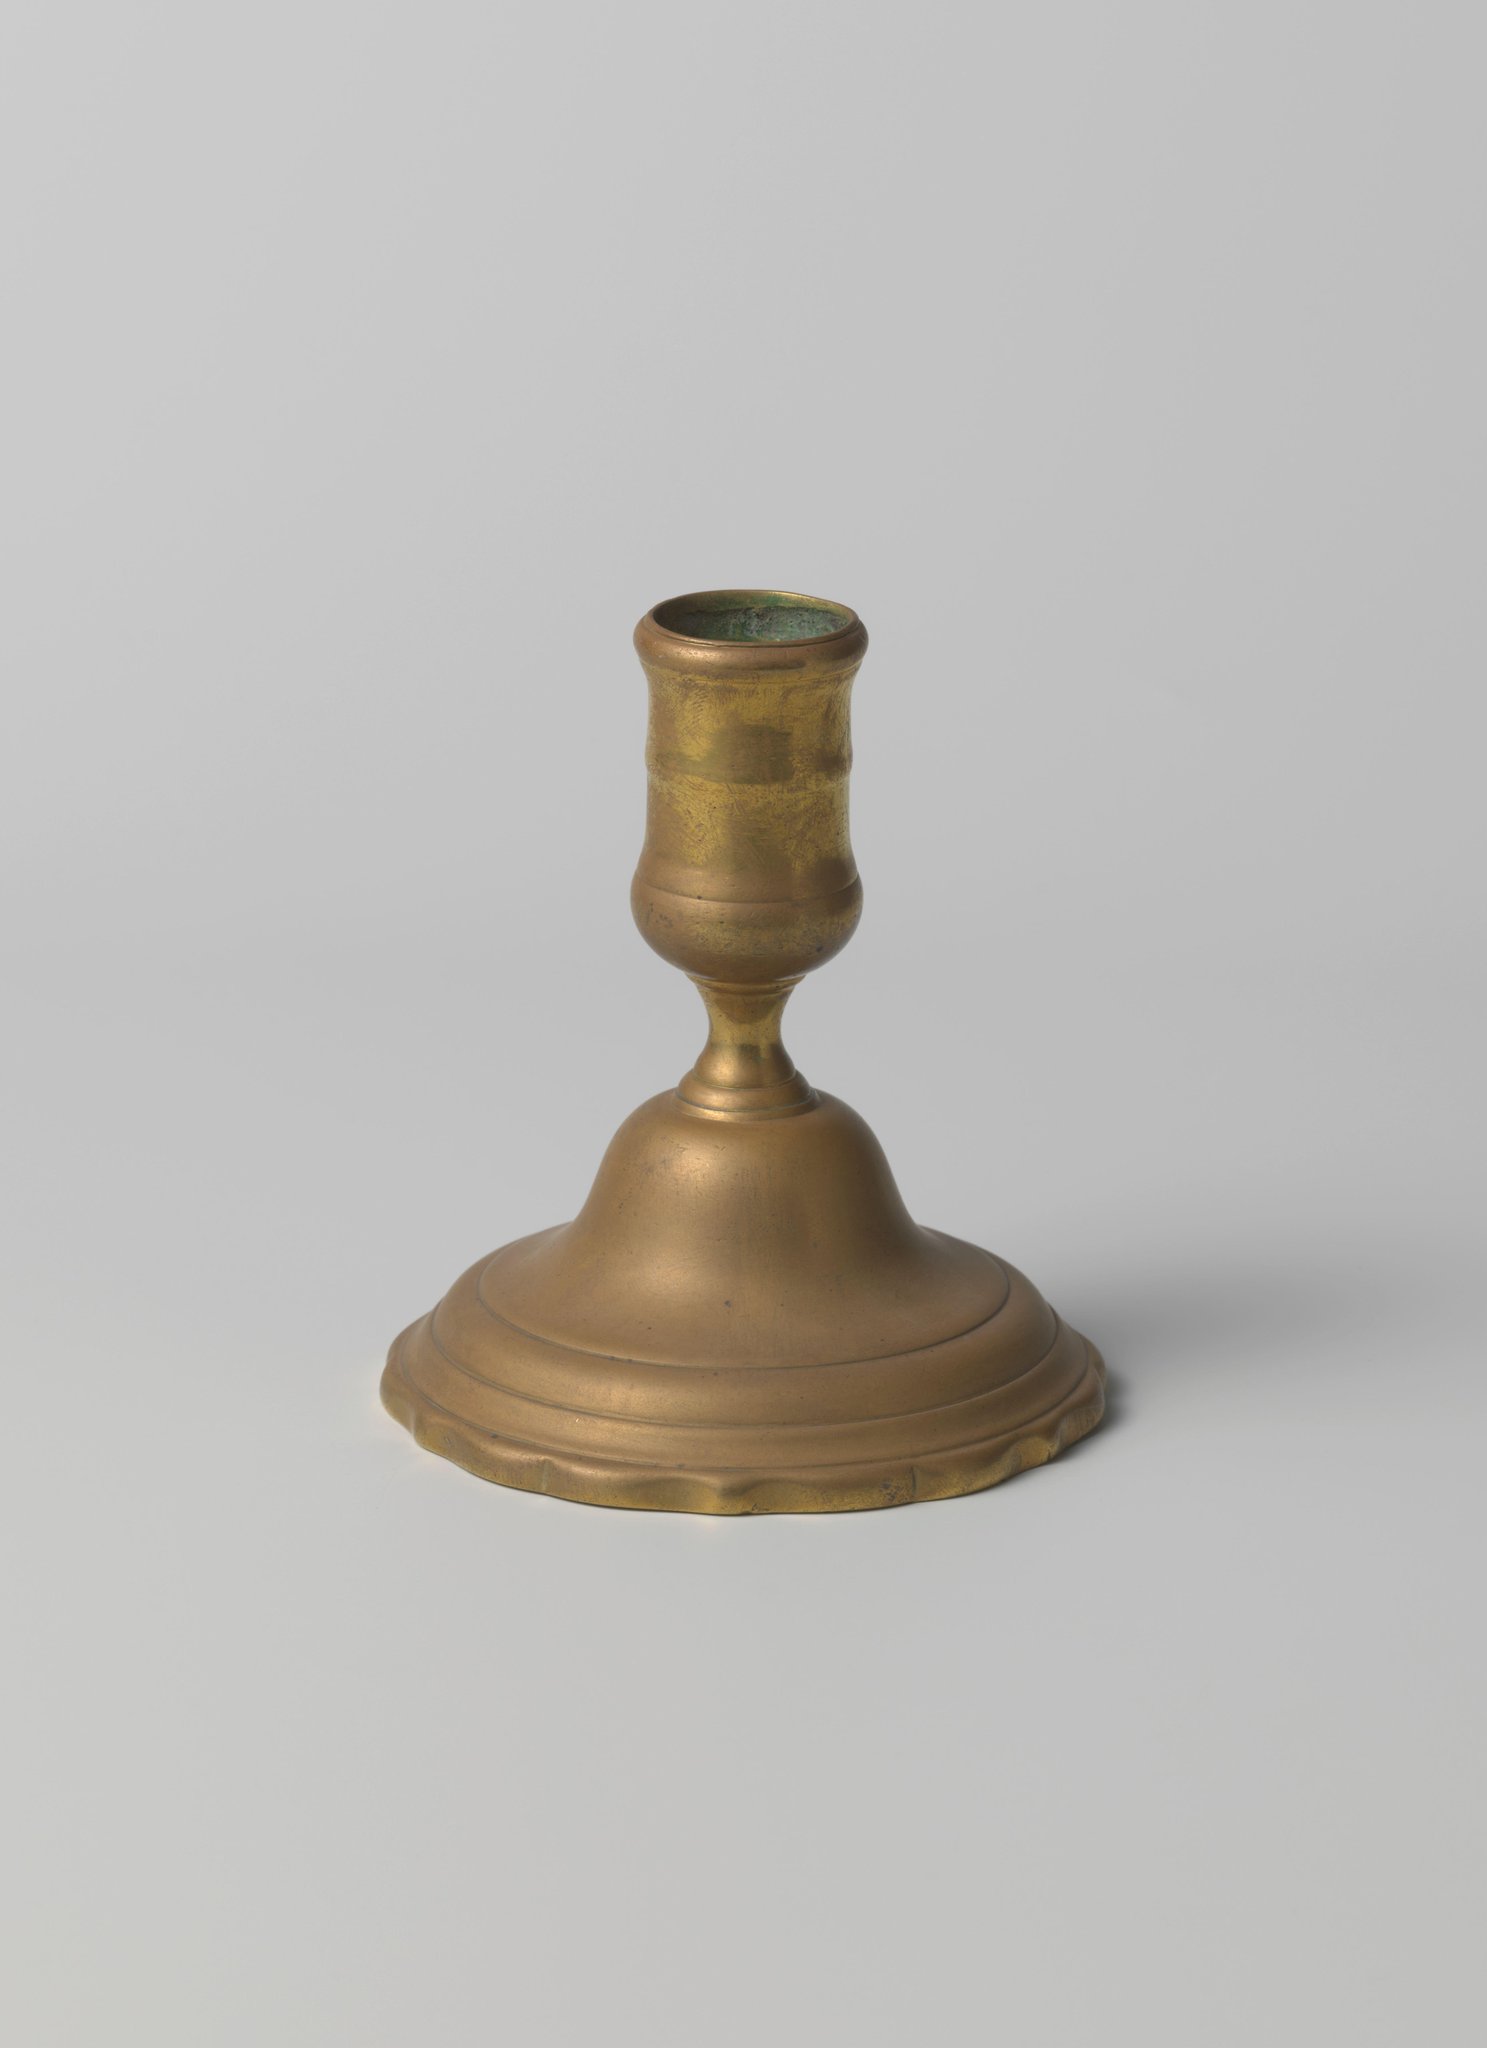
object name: candlestick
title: Kandelaar van messing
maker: Anonymous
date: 1800-1900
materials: brass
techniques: casting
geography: netherlands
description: De kaarsenhouder is in twee delen gegoten, de voet als één geheel. Aan de onderkant van de voet zijn de houders opnieuw met tin bevestigd. De conische voet heeft een in accoladeprofiel gekartelde rand. De enigszins cylindrisch gevormde houder is met flauwe ribben versierd.